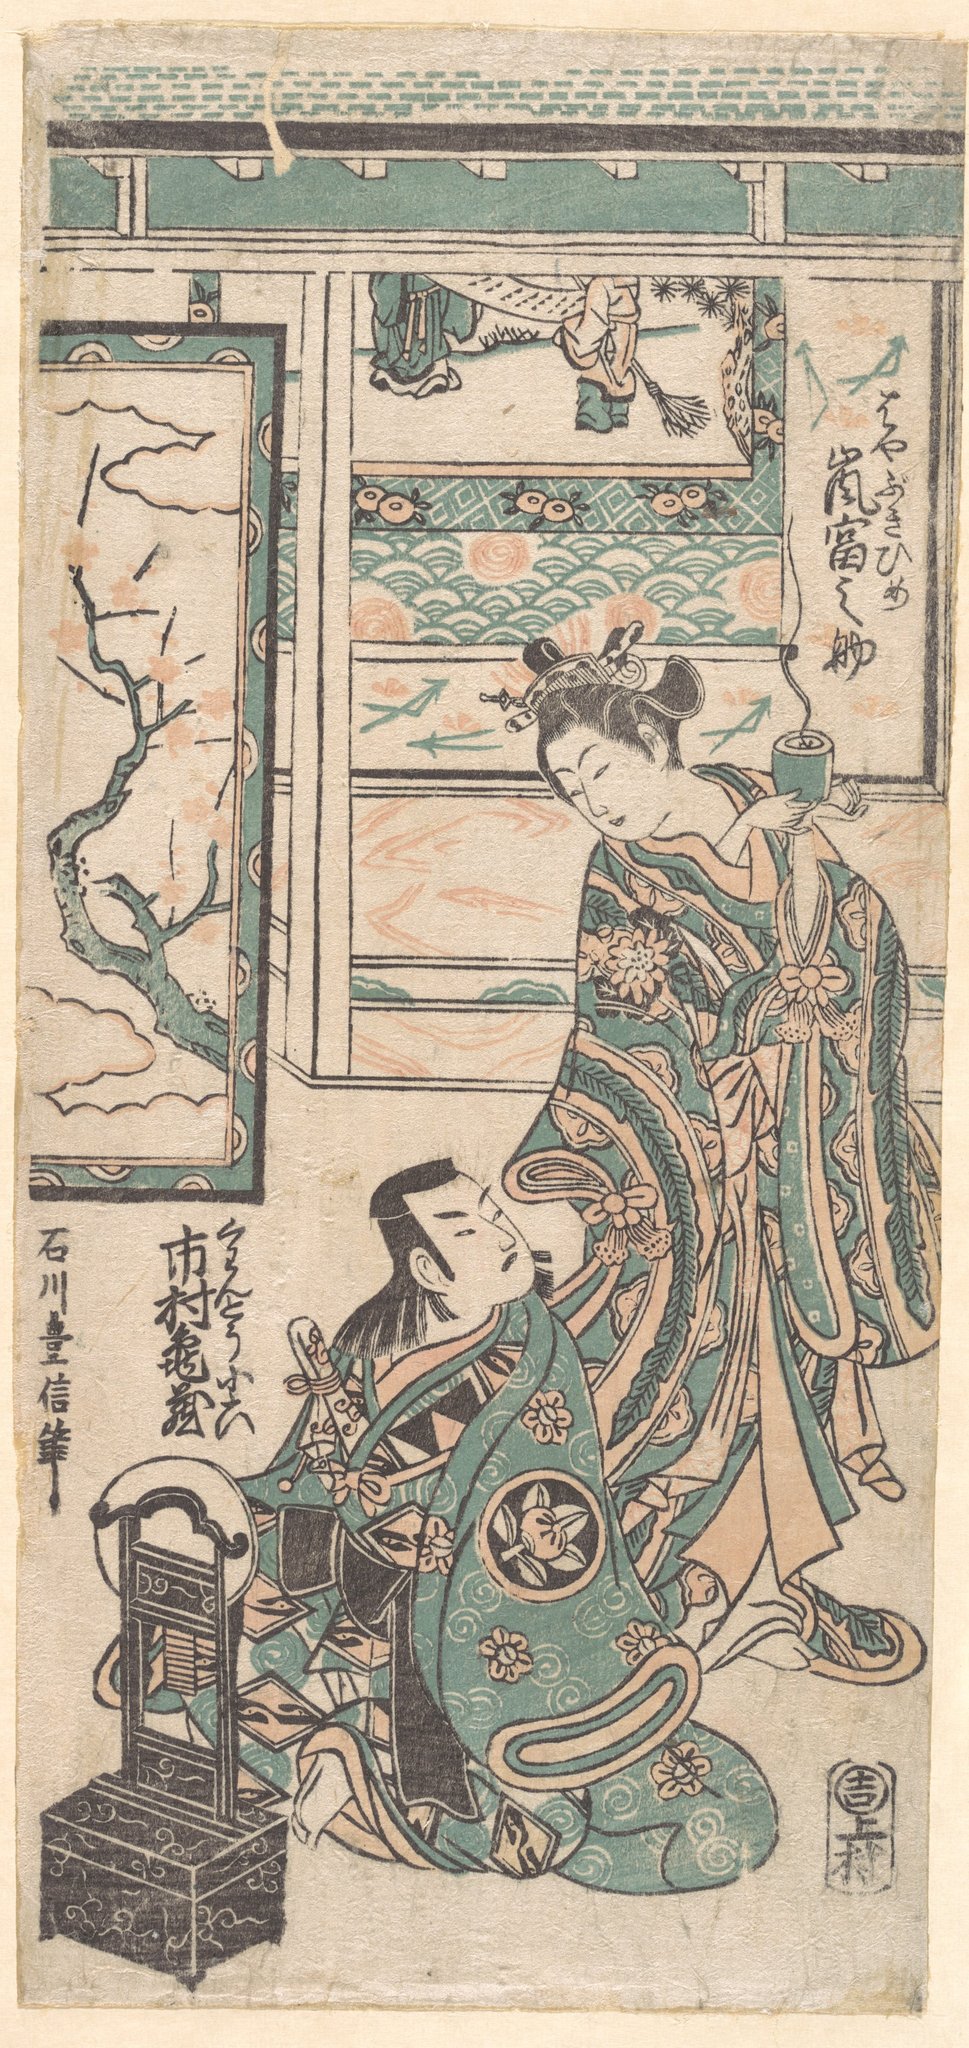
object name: print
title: The Actor Arashi Tominosuke (Standing) in the Role of Hyasakihime, and Ichimura Kamezo as Kanto Koroku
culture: japanese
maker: ishikawa toyonobu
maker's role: artist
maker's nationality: japanese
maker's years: 1711-1785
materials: ink, paper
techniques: woodblock print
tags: men,women,actors